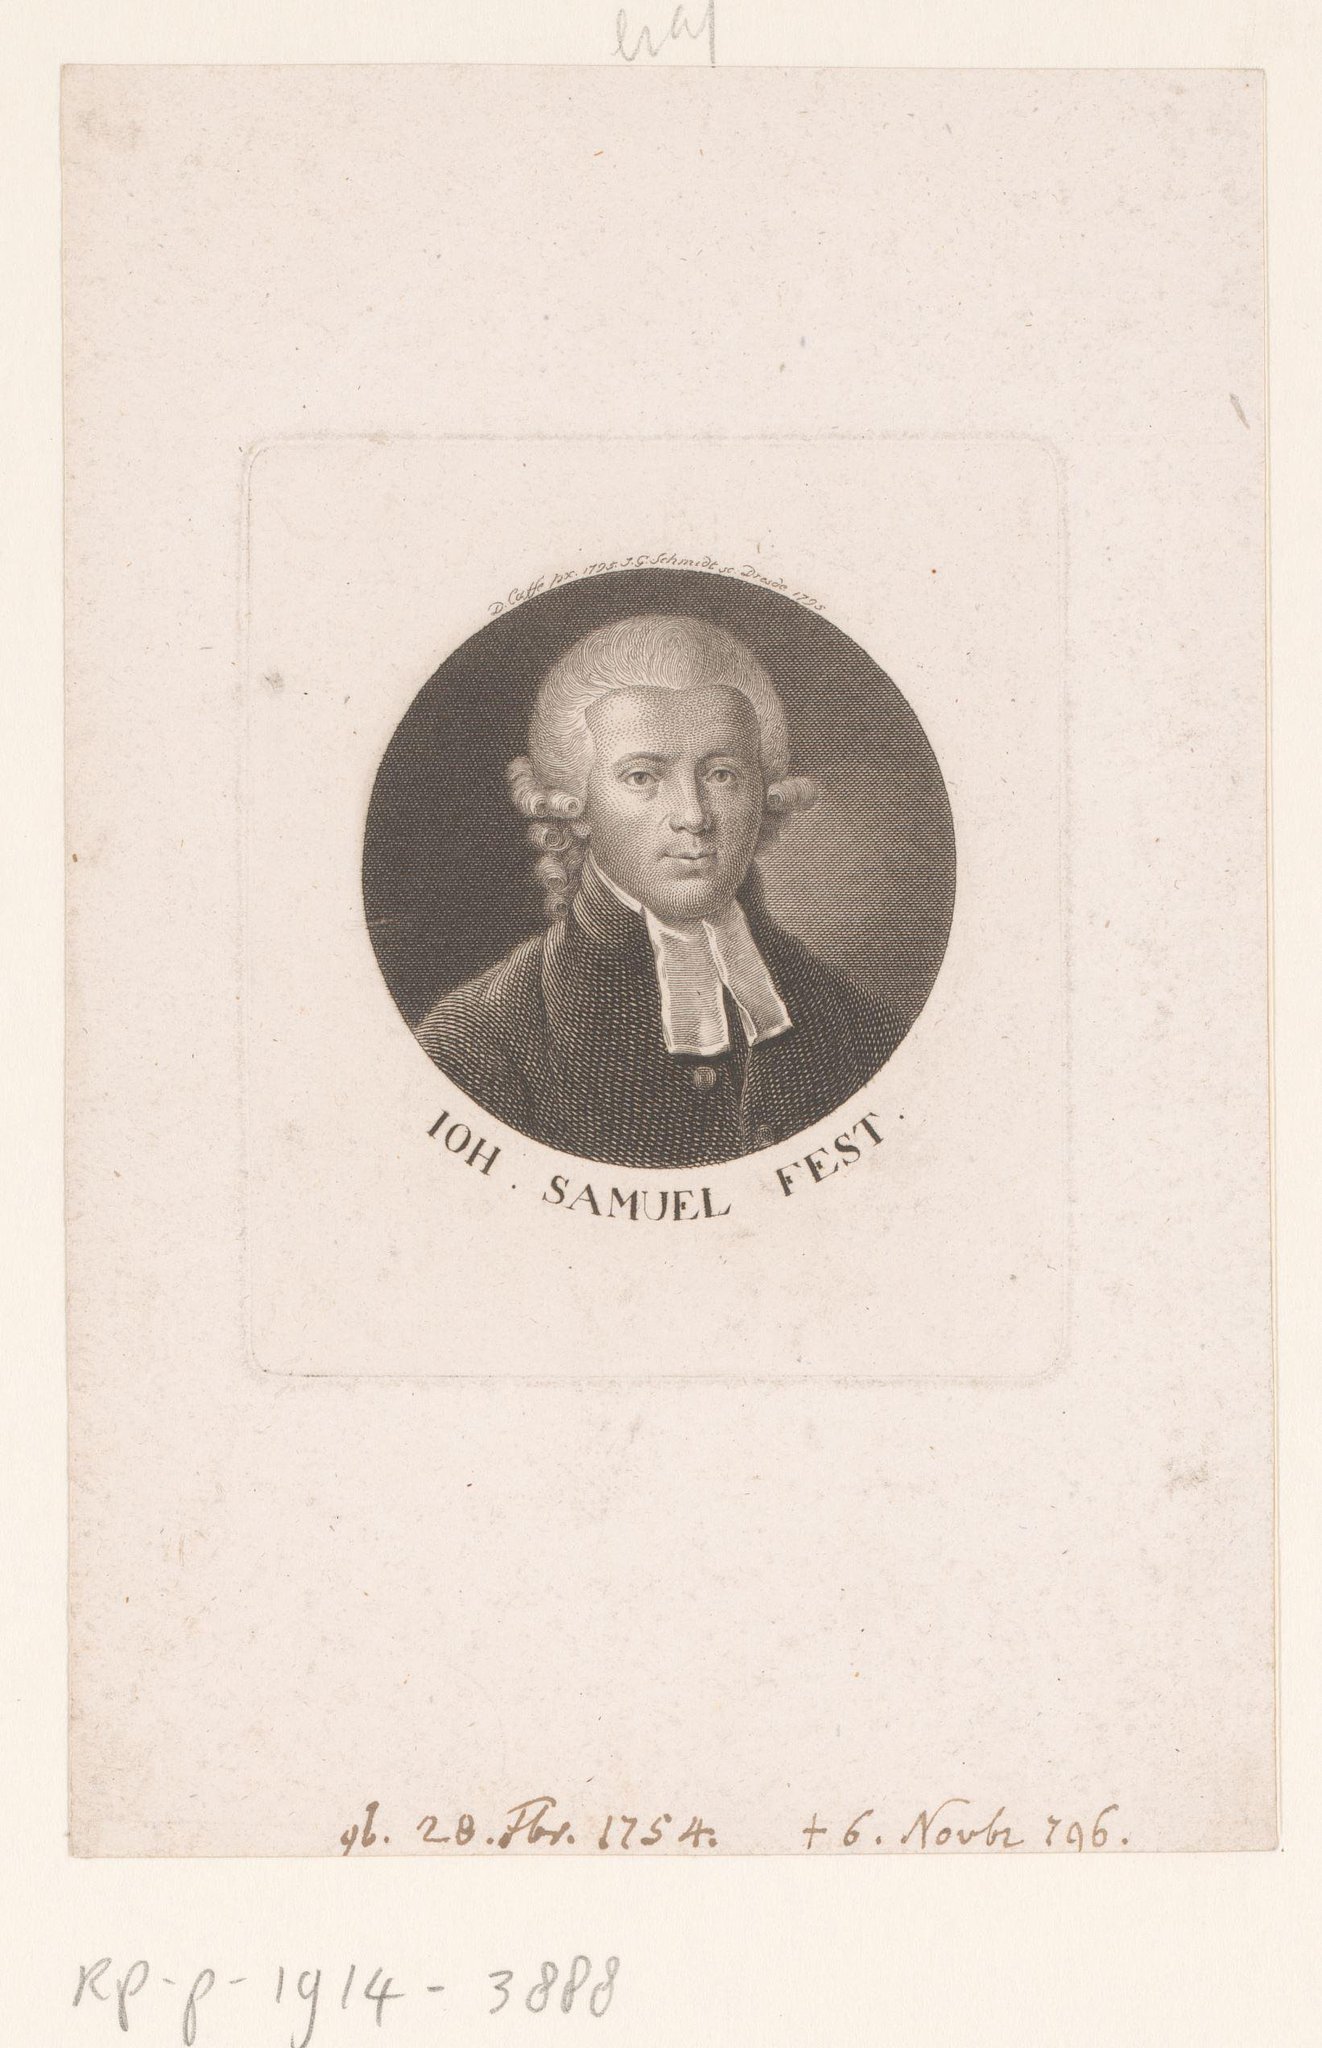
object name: print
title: Portret van Johann Samuel Fest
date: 1795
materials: paper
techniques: engraving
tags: historical persons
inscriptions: collector's mark: Lugt 2228